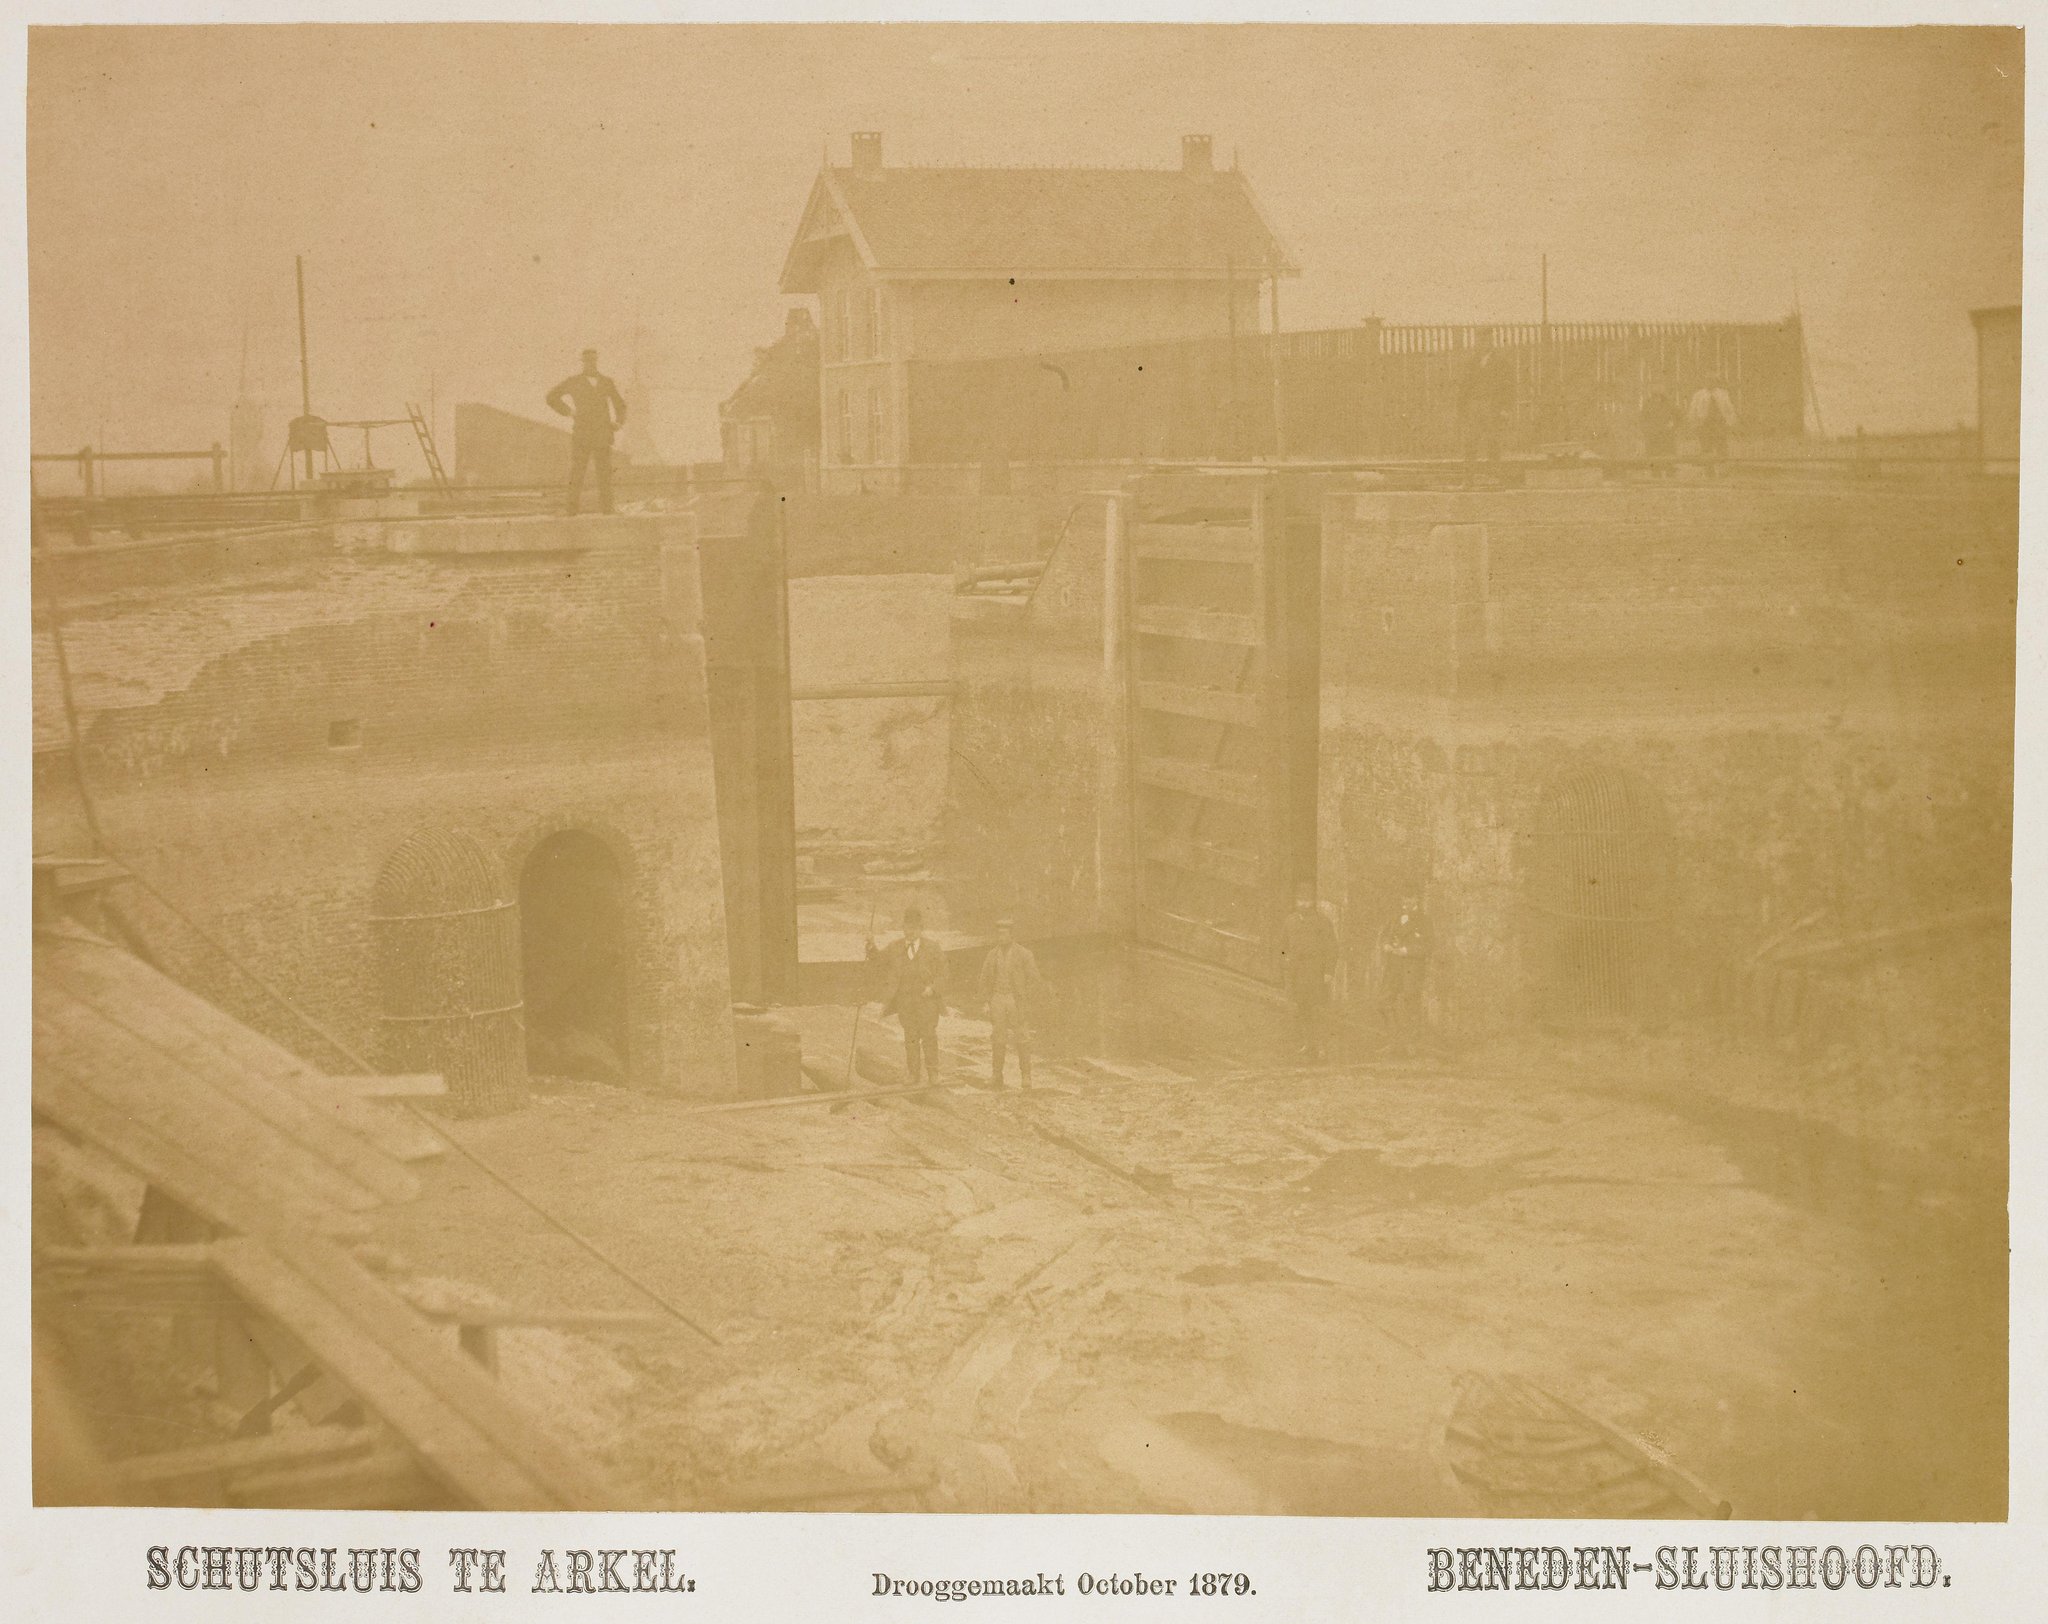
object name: photograph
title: Schutsluis te Arkel, 1879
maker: Anonymous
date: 1879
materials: cardboard, paper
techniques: albumen print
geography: arkel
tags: arkel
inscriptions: inscription: ‘Schutsluis te Arkel. Drooggemaakt October 1879. Beneden-sluishoofd.’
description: Werkzaamheden aan de benedensluishoofd. Onderdeel van een serie van vier foto's op karton van de droogmaking van de schutsluis te Arkel in oktober 1879.